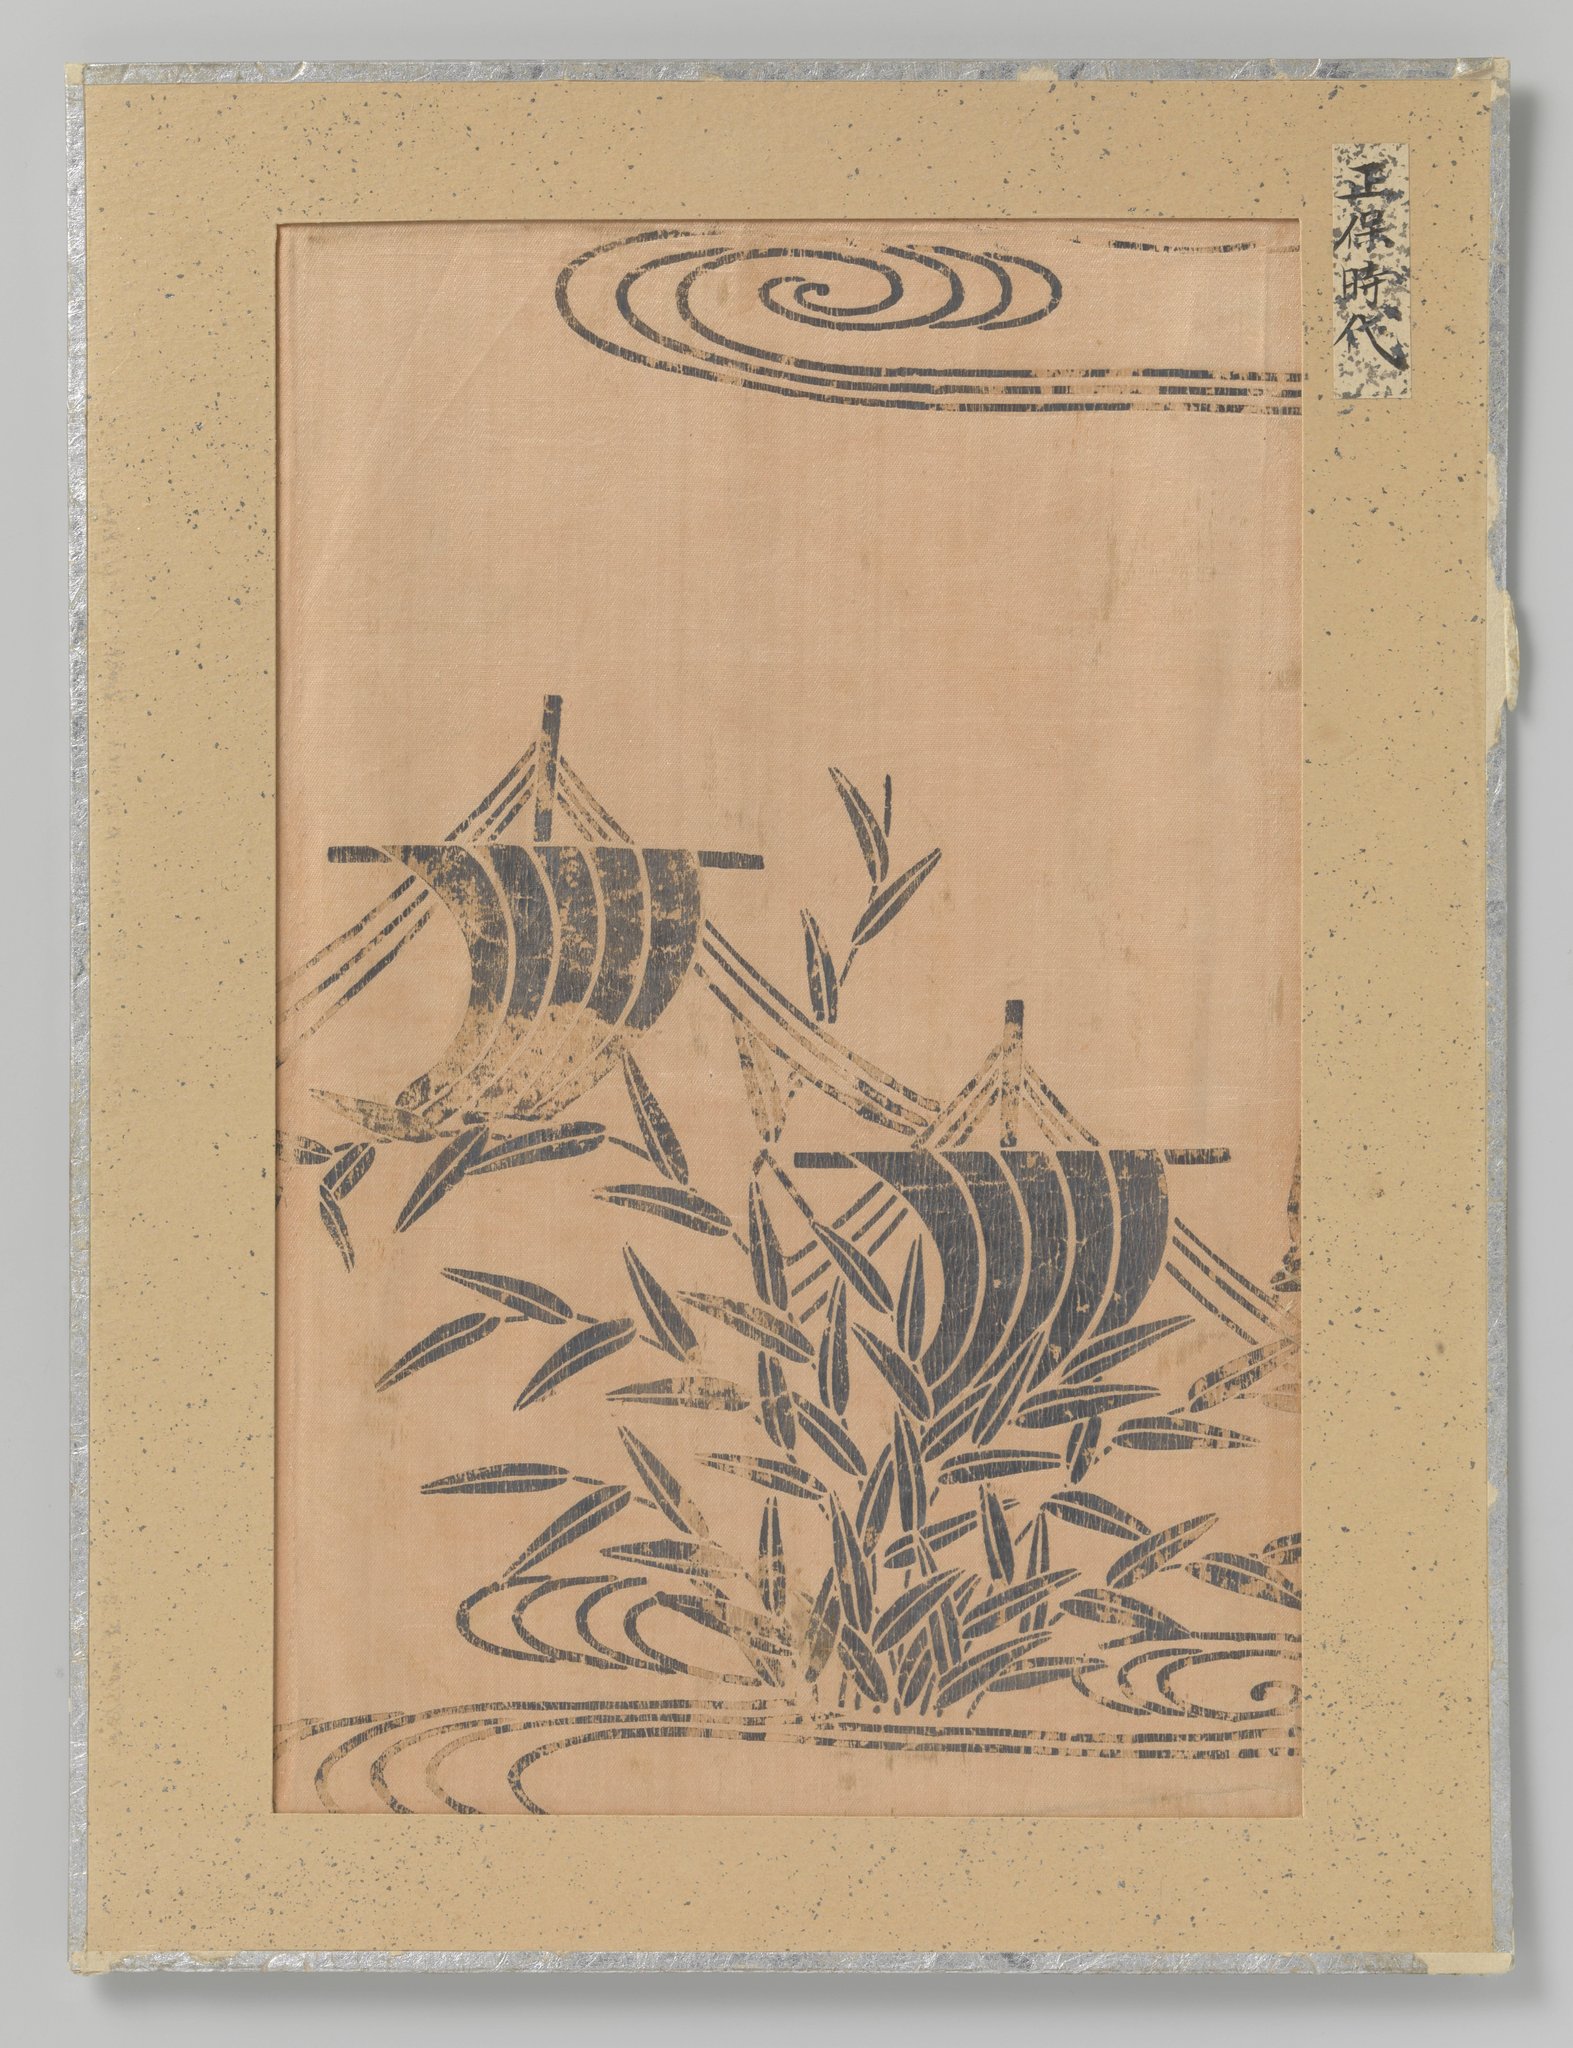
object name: textile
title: Textielfragment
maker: Anonymous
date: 1644-1648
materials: silk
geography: japan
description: Textielfragment, zilver-versiering van bamboe en zeilen op roze zijden fond.